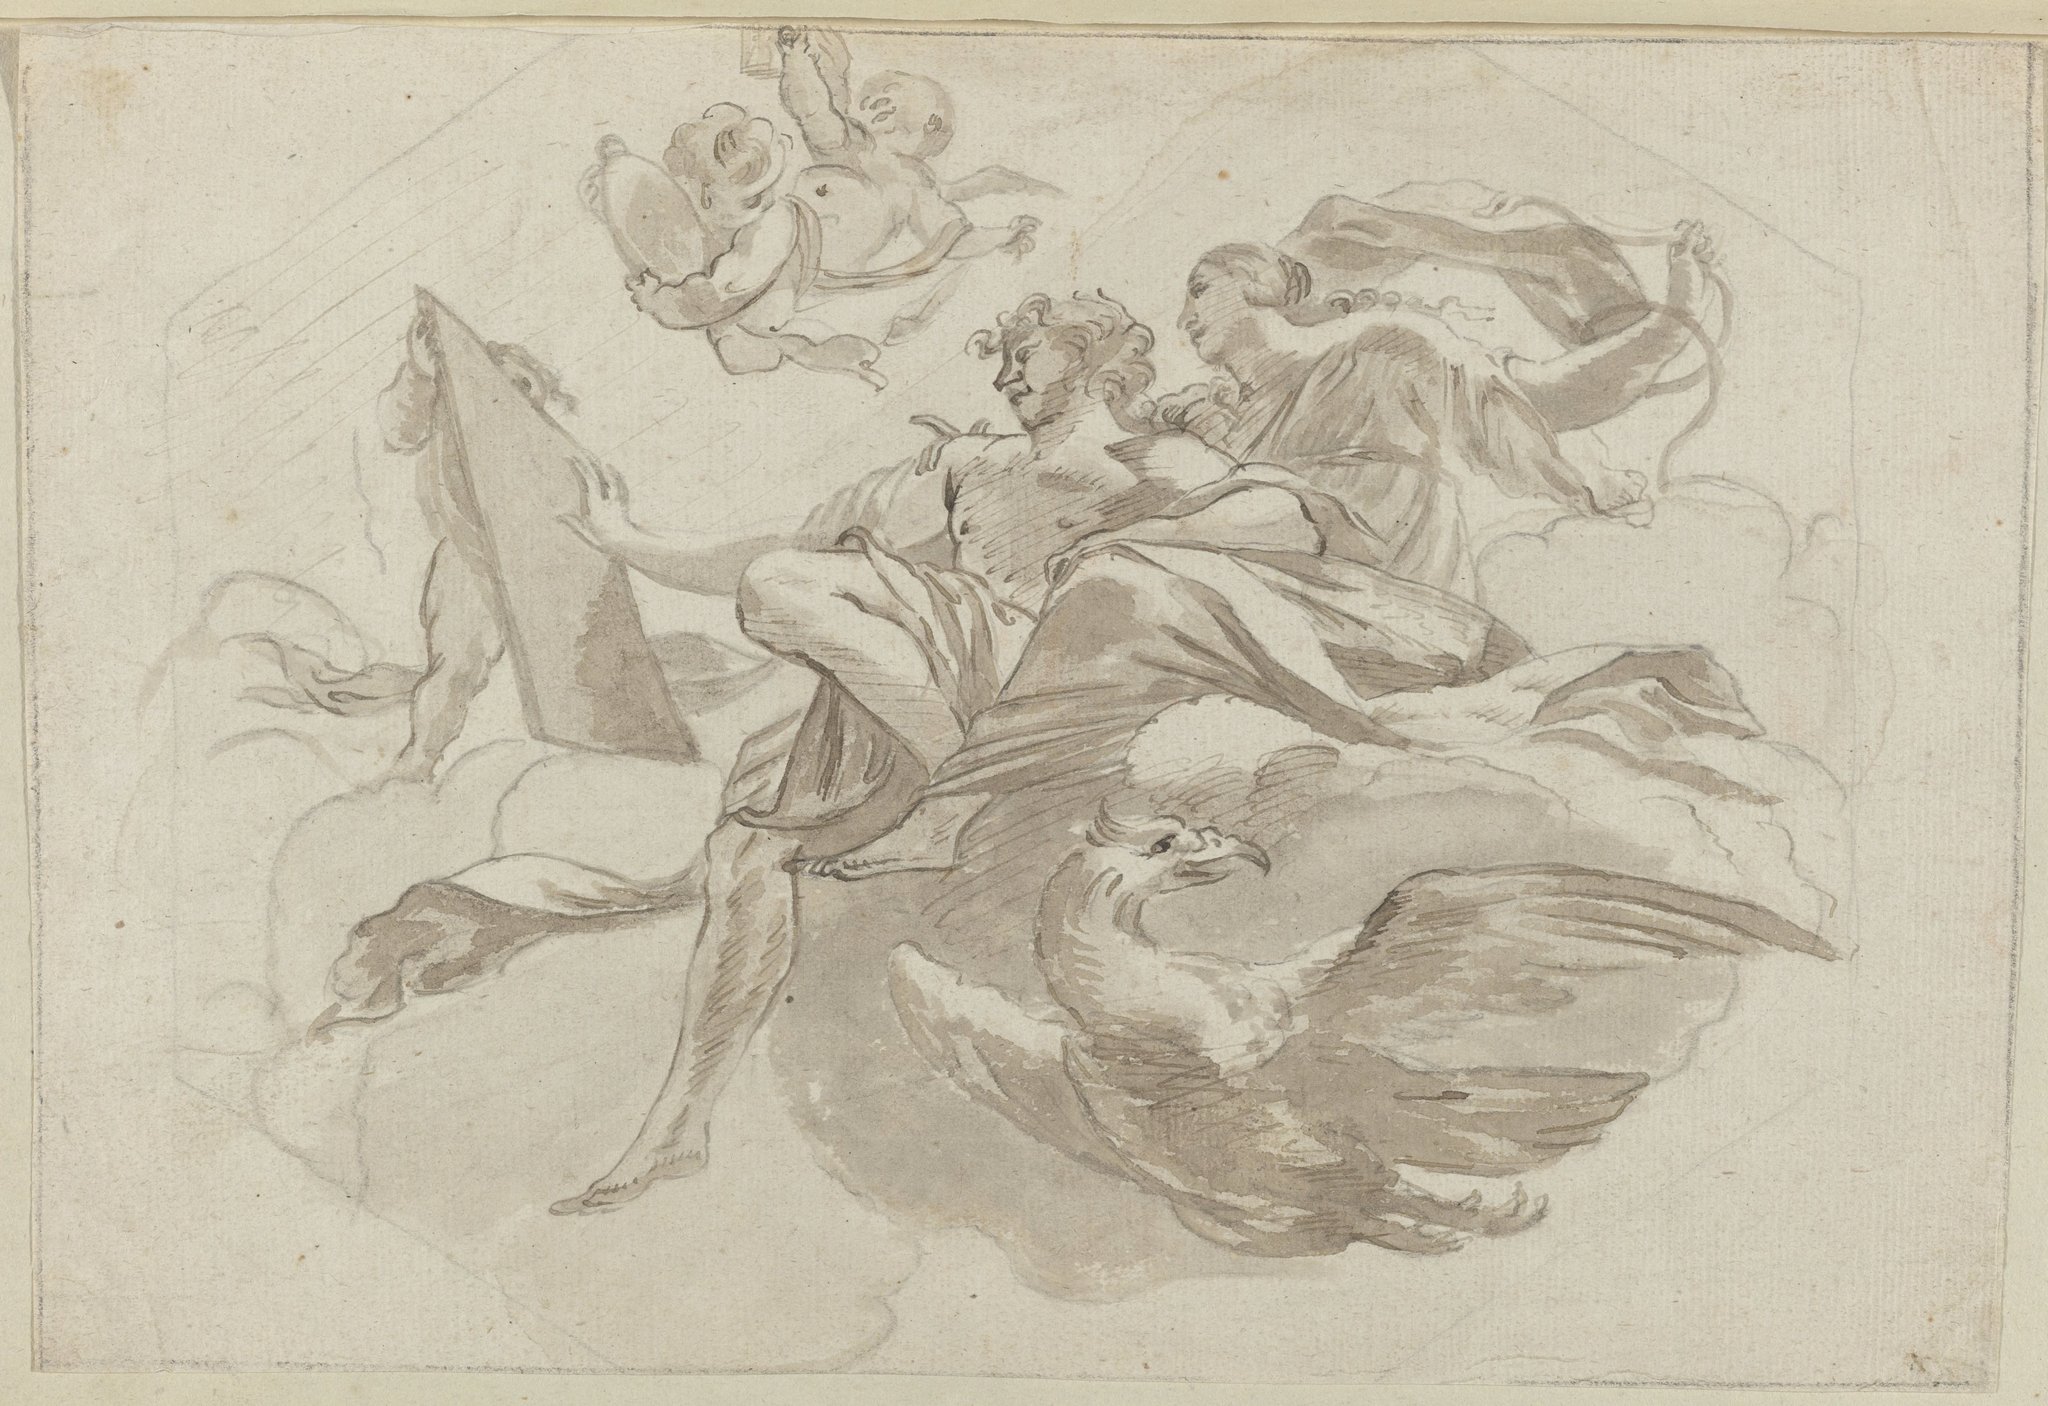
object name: drawing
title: Mensfiguren en putti met een adelaar in de wolken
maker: Anonymous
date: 1700-1799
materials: ink, paper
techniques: brush, pen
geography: netherlands